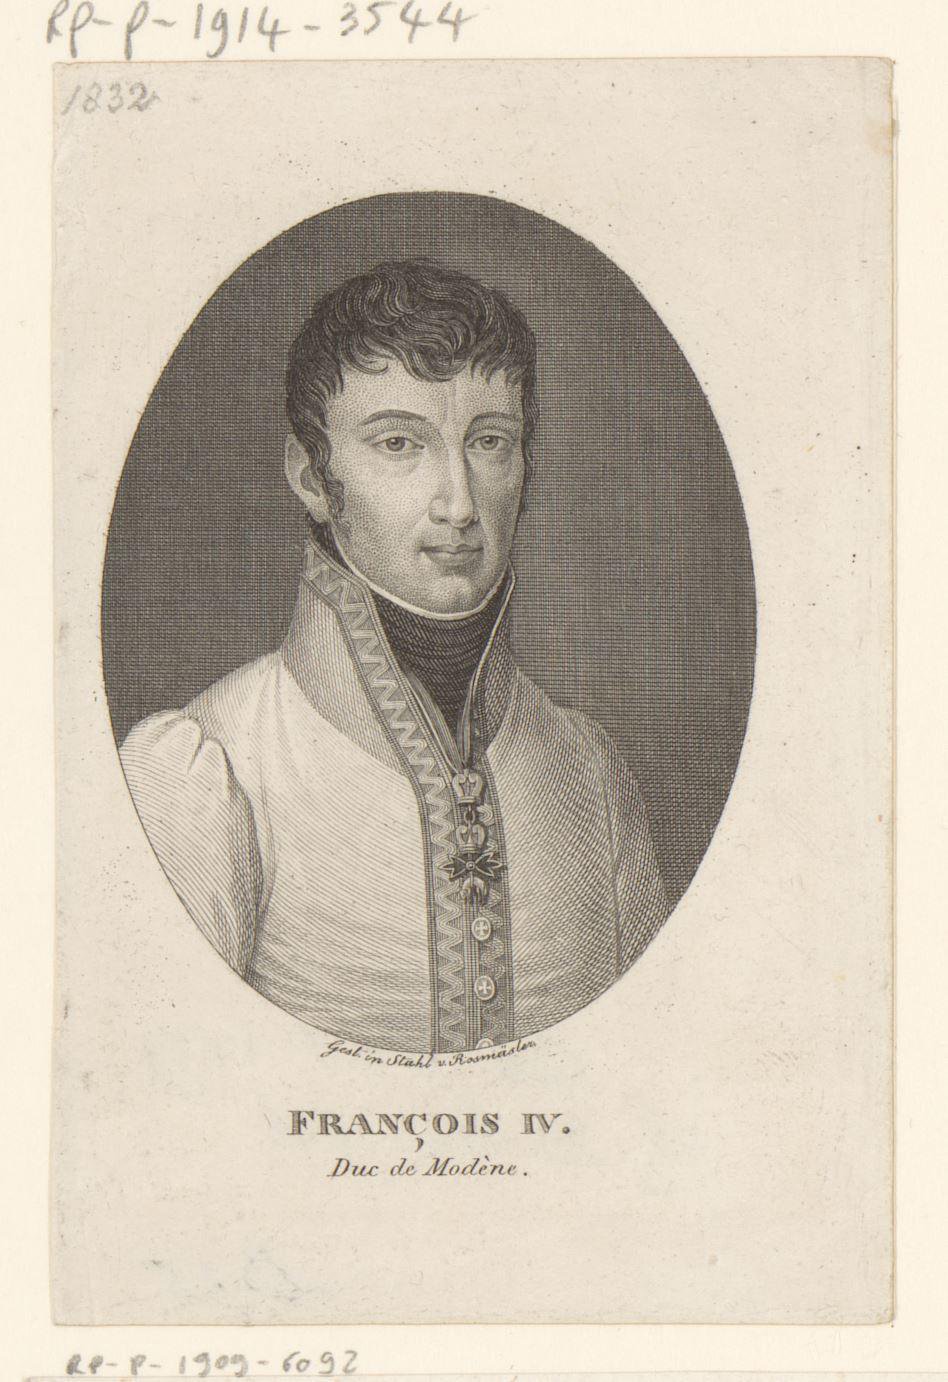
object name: print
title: Portret van Frans IV van Modena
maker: friedrich rossmässler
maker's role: print maker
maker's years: 1775-1858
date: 1785-1858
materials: paper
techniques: engraving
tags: historical persons, knighthood order of the golden fleece - insignia of a knighthood order, e.g.: badge, chain (with name of order)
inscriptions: collector's mark: Lugt 2228, date: ‘1832’